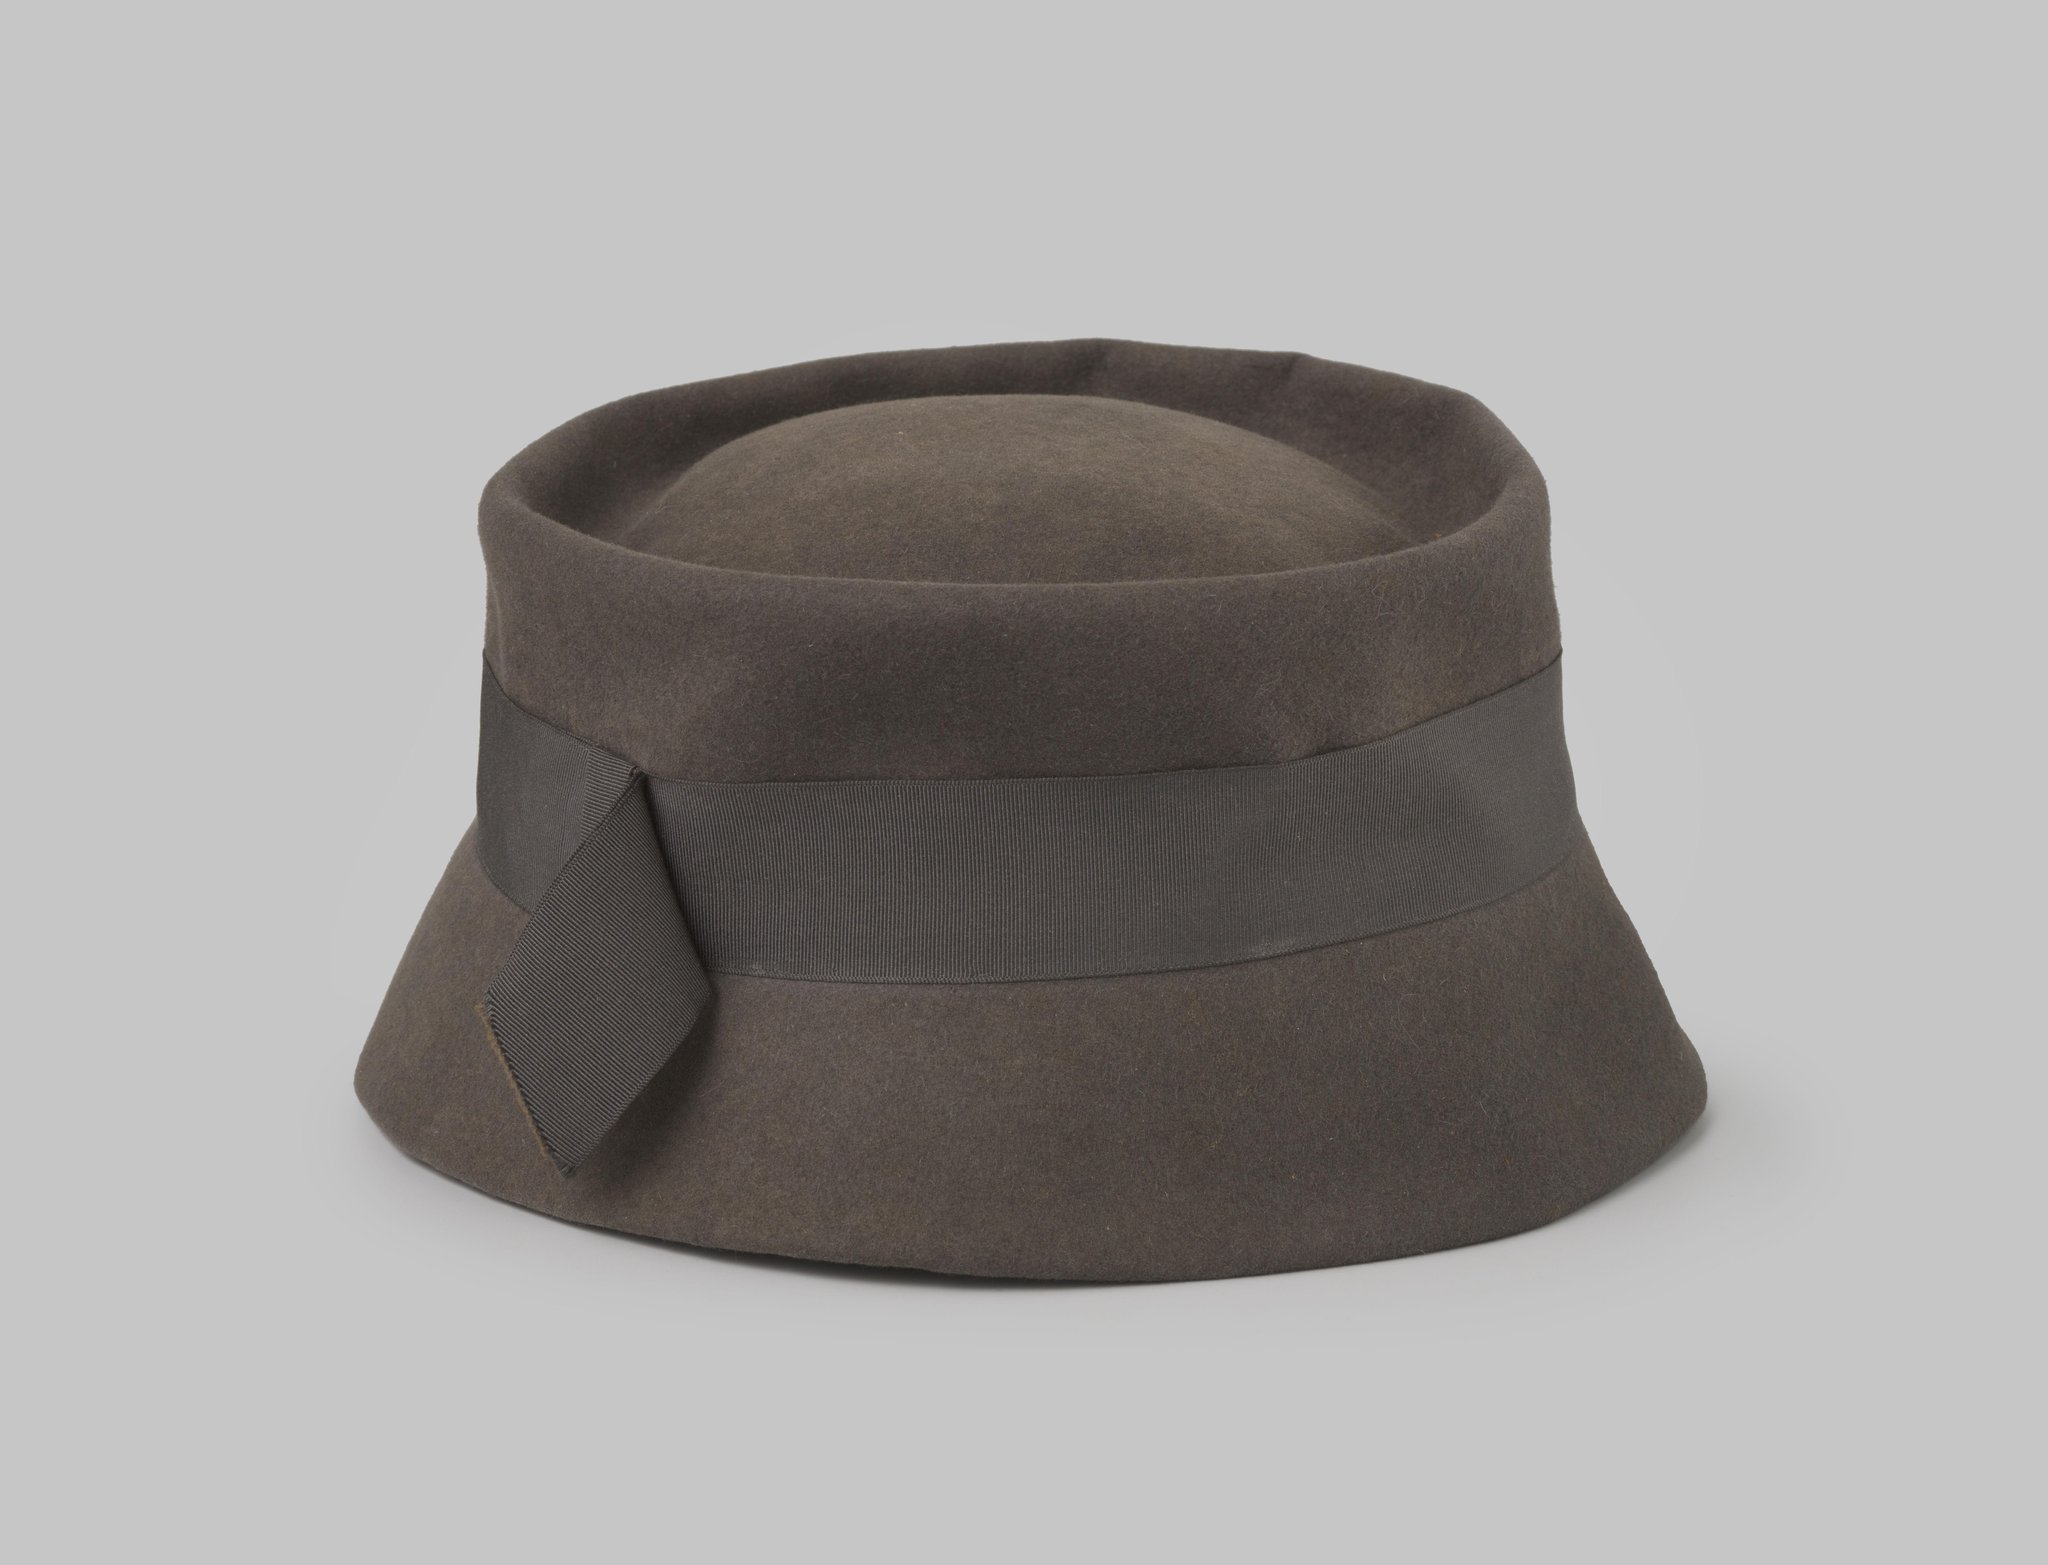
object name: hat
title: Hoed van grijs vilt met grijs ripslint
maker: t.c.c.m. hoogland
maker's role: hoedenmaker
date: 1950-1960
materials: felt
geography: utrecht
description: Hoed van grijs vilt met grijs ripslint. Model: cloche met overhangende rand. Merk: FLECHET/PARIS; nr. b: Modesalon Hoogland. Parijs, Utrecht, ca. 1950-1960.